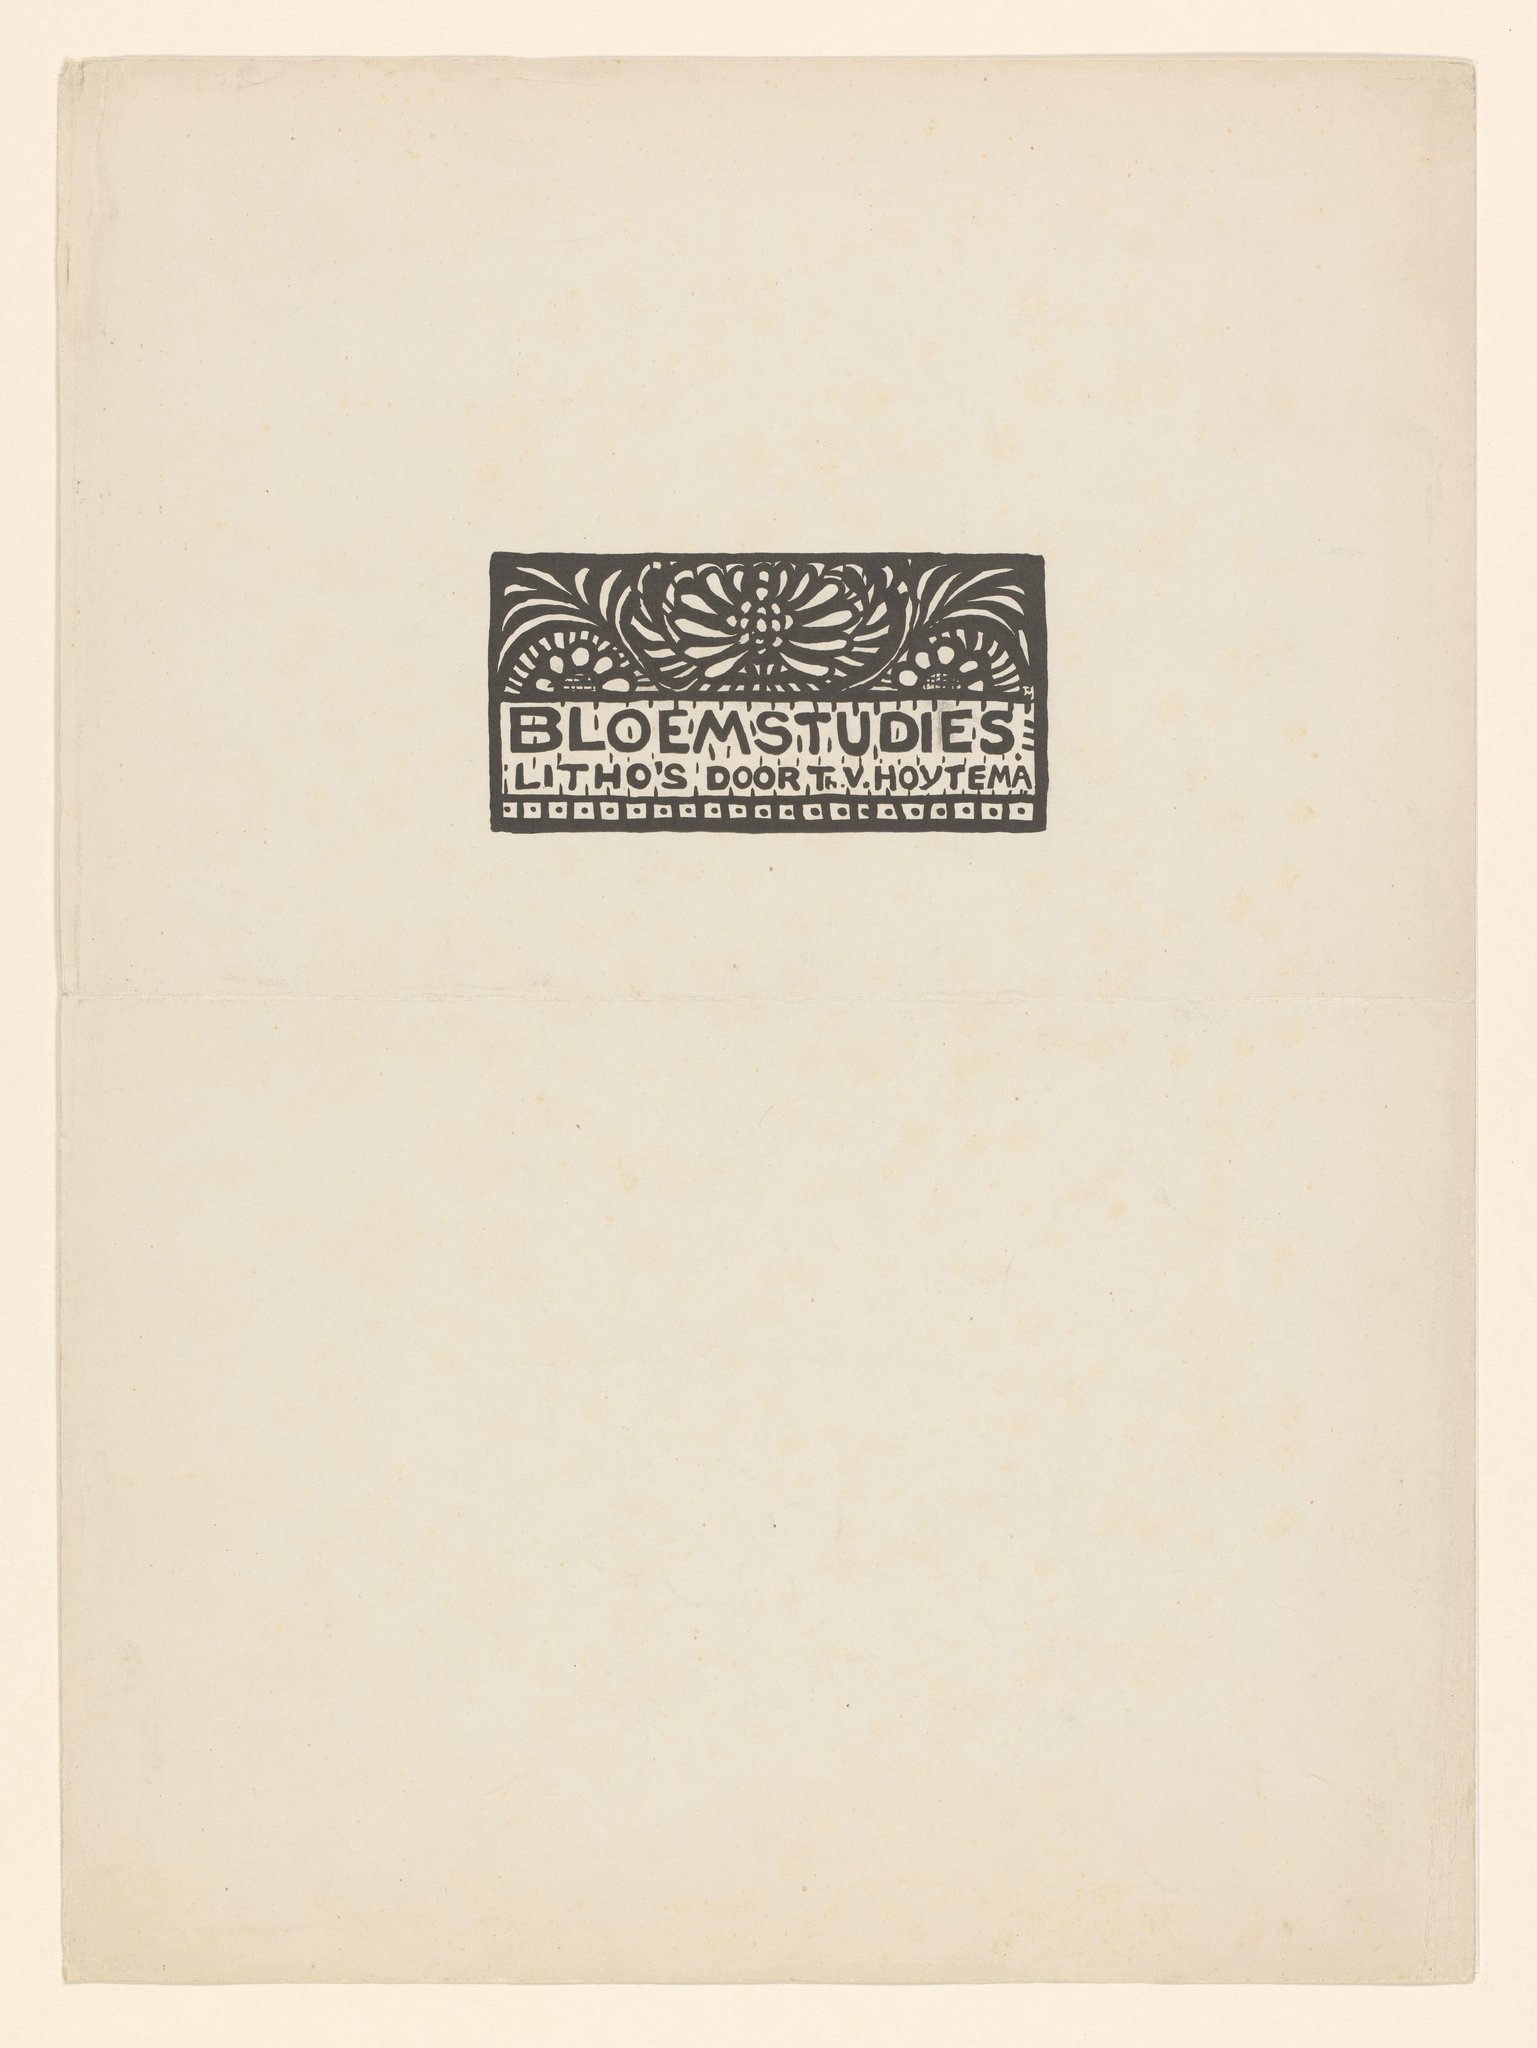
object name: titelprent, frontispice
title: Titelprent voor de serie 'Bloemstudies'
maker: theo van hoytema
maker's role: draughtsman, painter, print maker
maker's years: 1863-1917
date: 1905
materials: paper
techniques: lithograph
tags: flowers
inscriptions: collector's mark: Lugt 2228